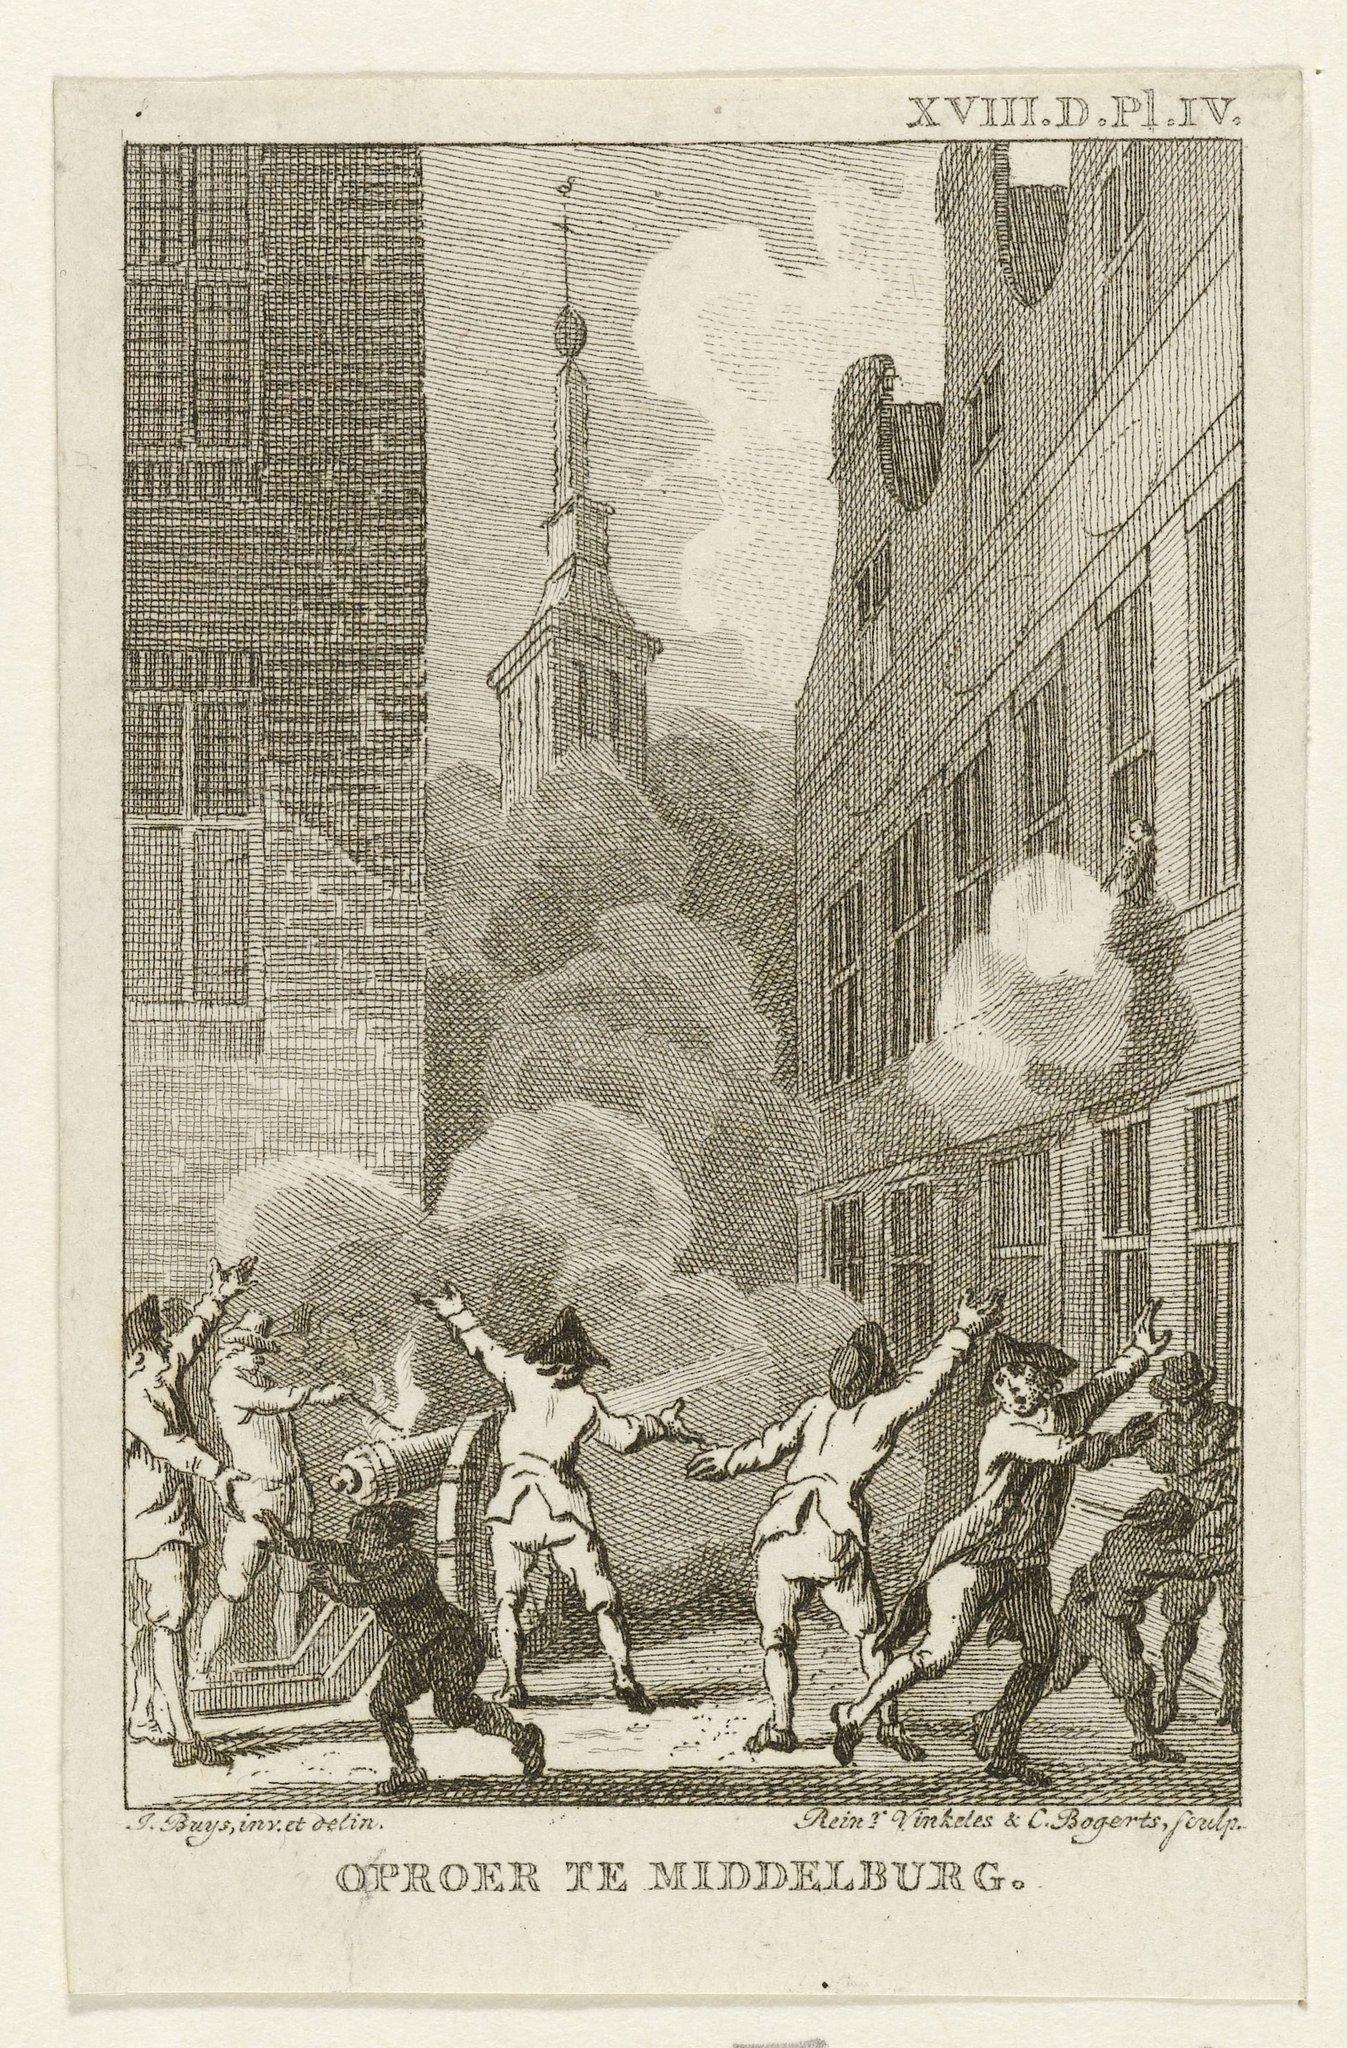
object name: print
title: Beschieting van het huis van Lucas van Steveninck, 1787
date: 1787-1795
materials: paper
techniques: engraving, etching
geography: northern netherlands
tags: amsterdam, street-fights, riots, patriots (1780-1795)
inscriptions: collector's mark: Lugt 2228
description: Oranjegezinden beschieten met een klein kanon het Huis Leeuwenburg te Middelburg van de patriotse arts Lucas van Steveninck, in de nacht van 30 juni op 1 juli 1787. De bewoners schieten vanuit de vensters van het huis met geweren terug. Gemerkt rechtsboven: XVIII.D.Pl.IV.